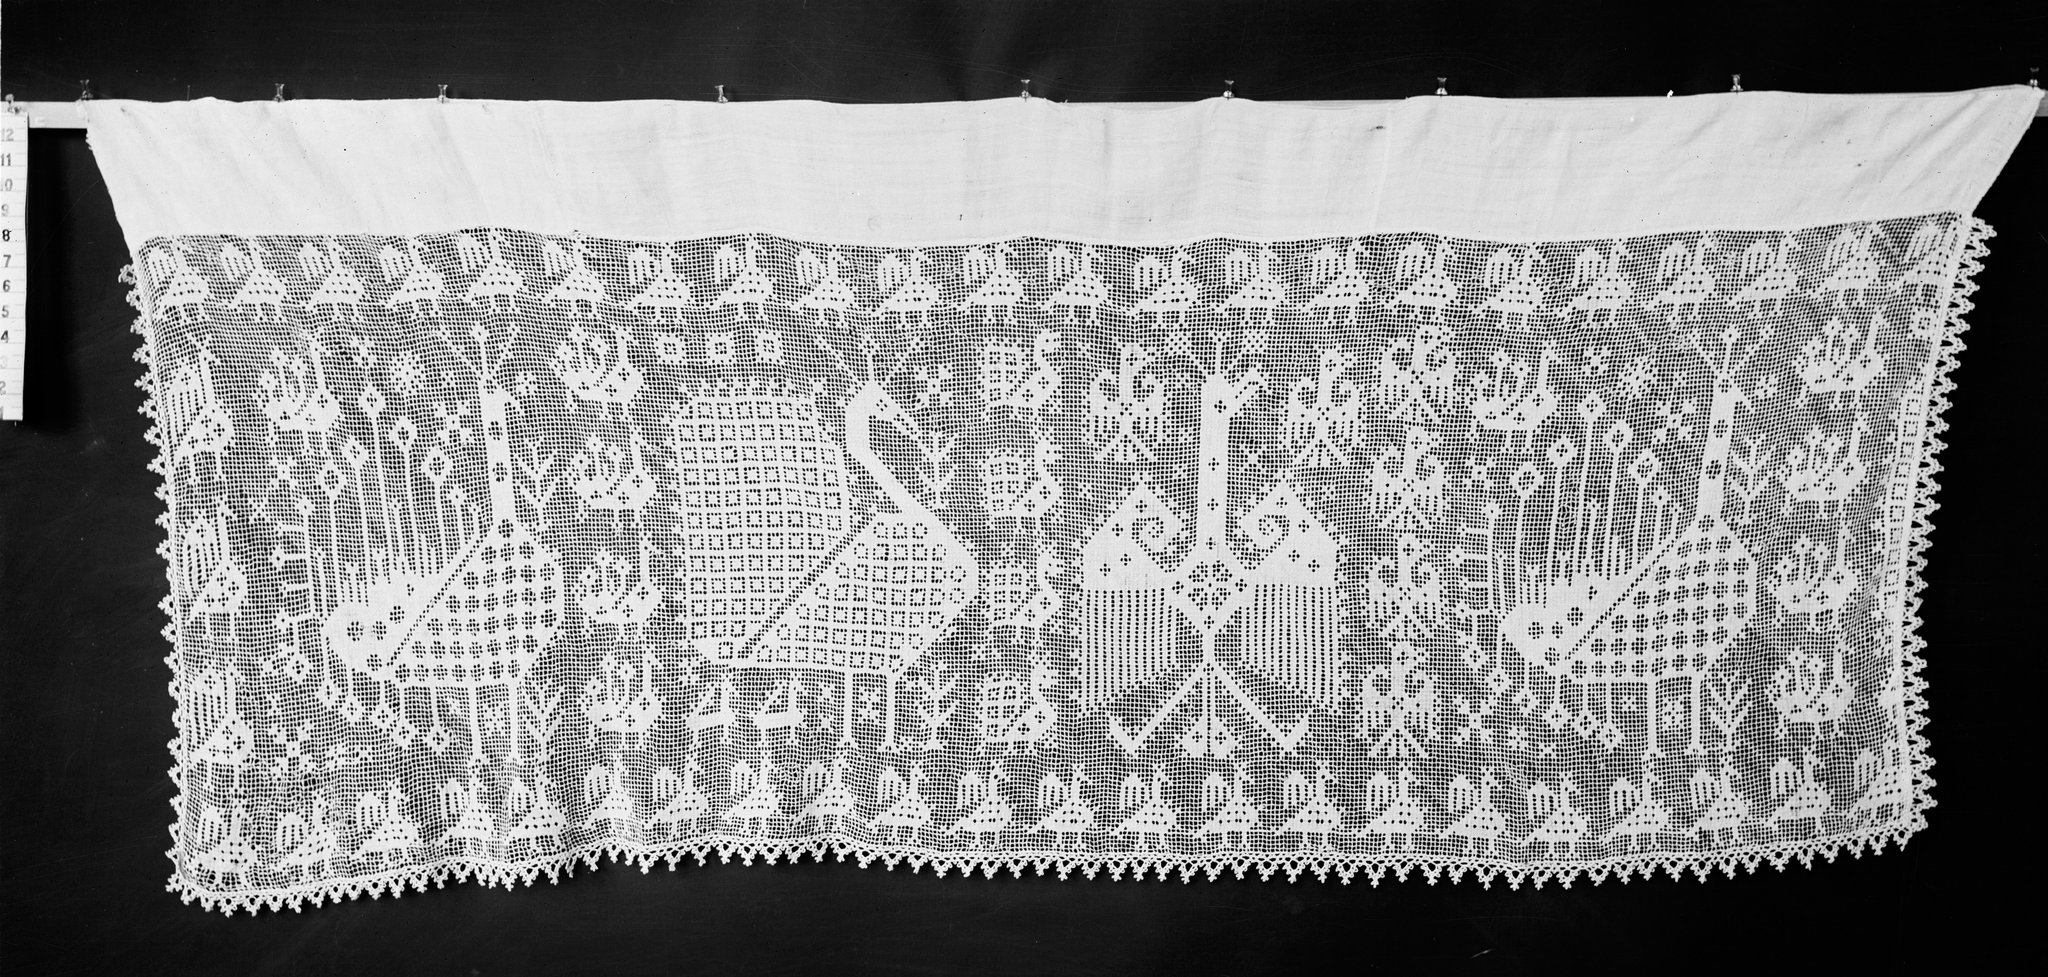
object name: hanging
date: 1501-1533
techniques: embroidery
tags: eagles,peacocks